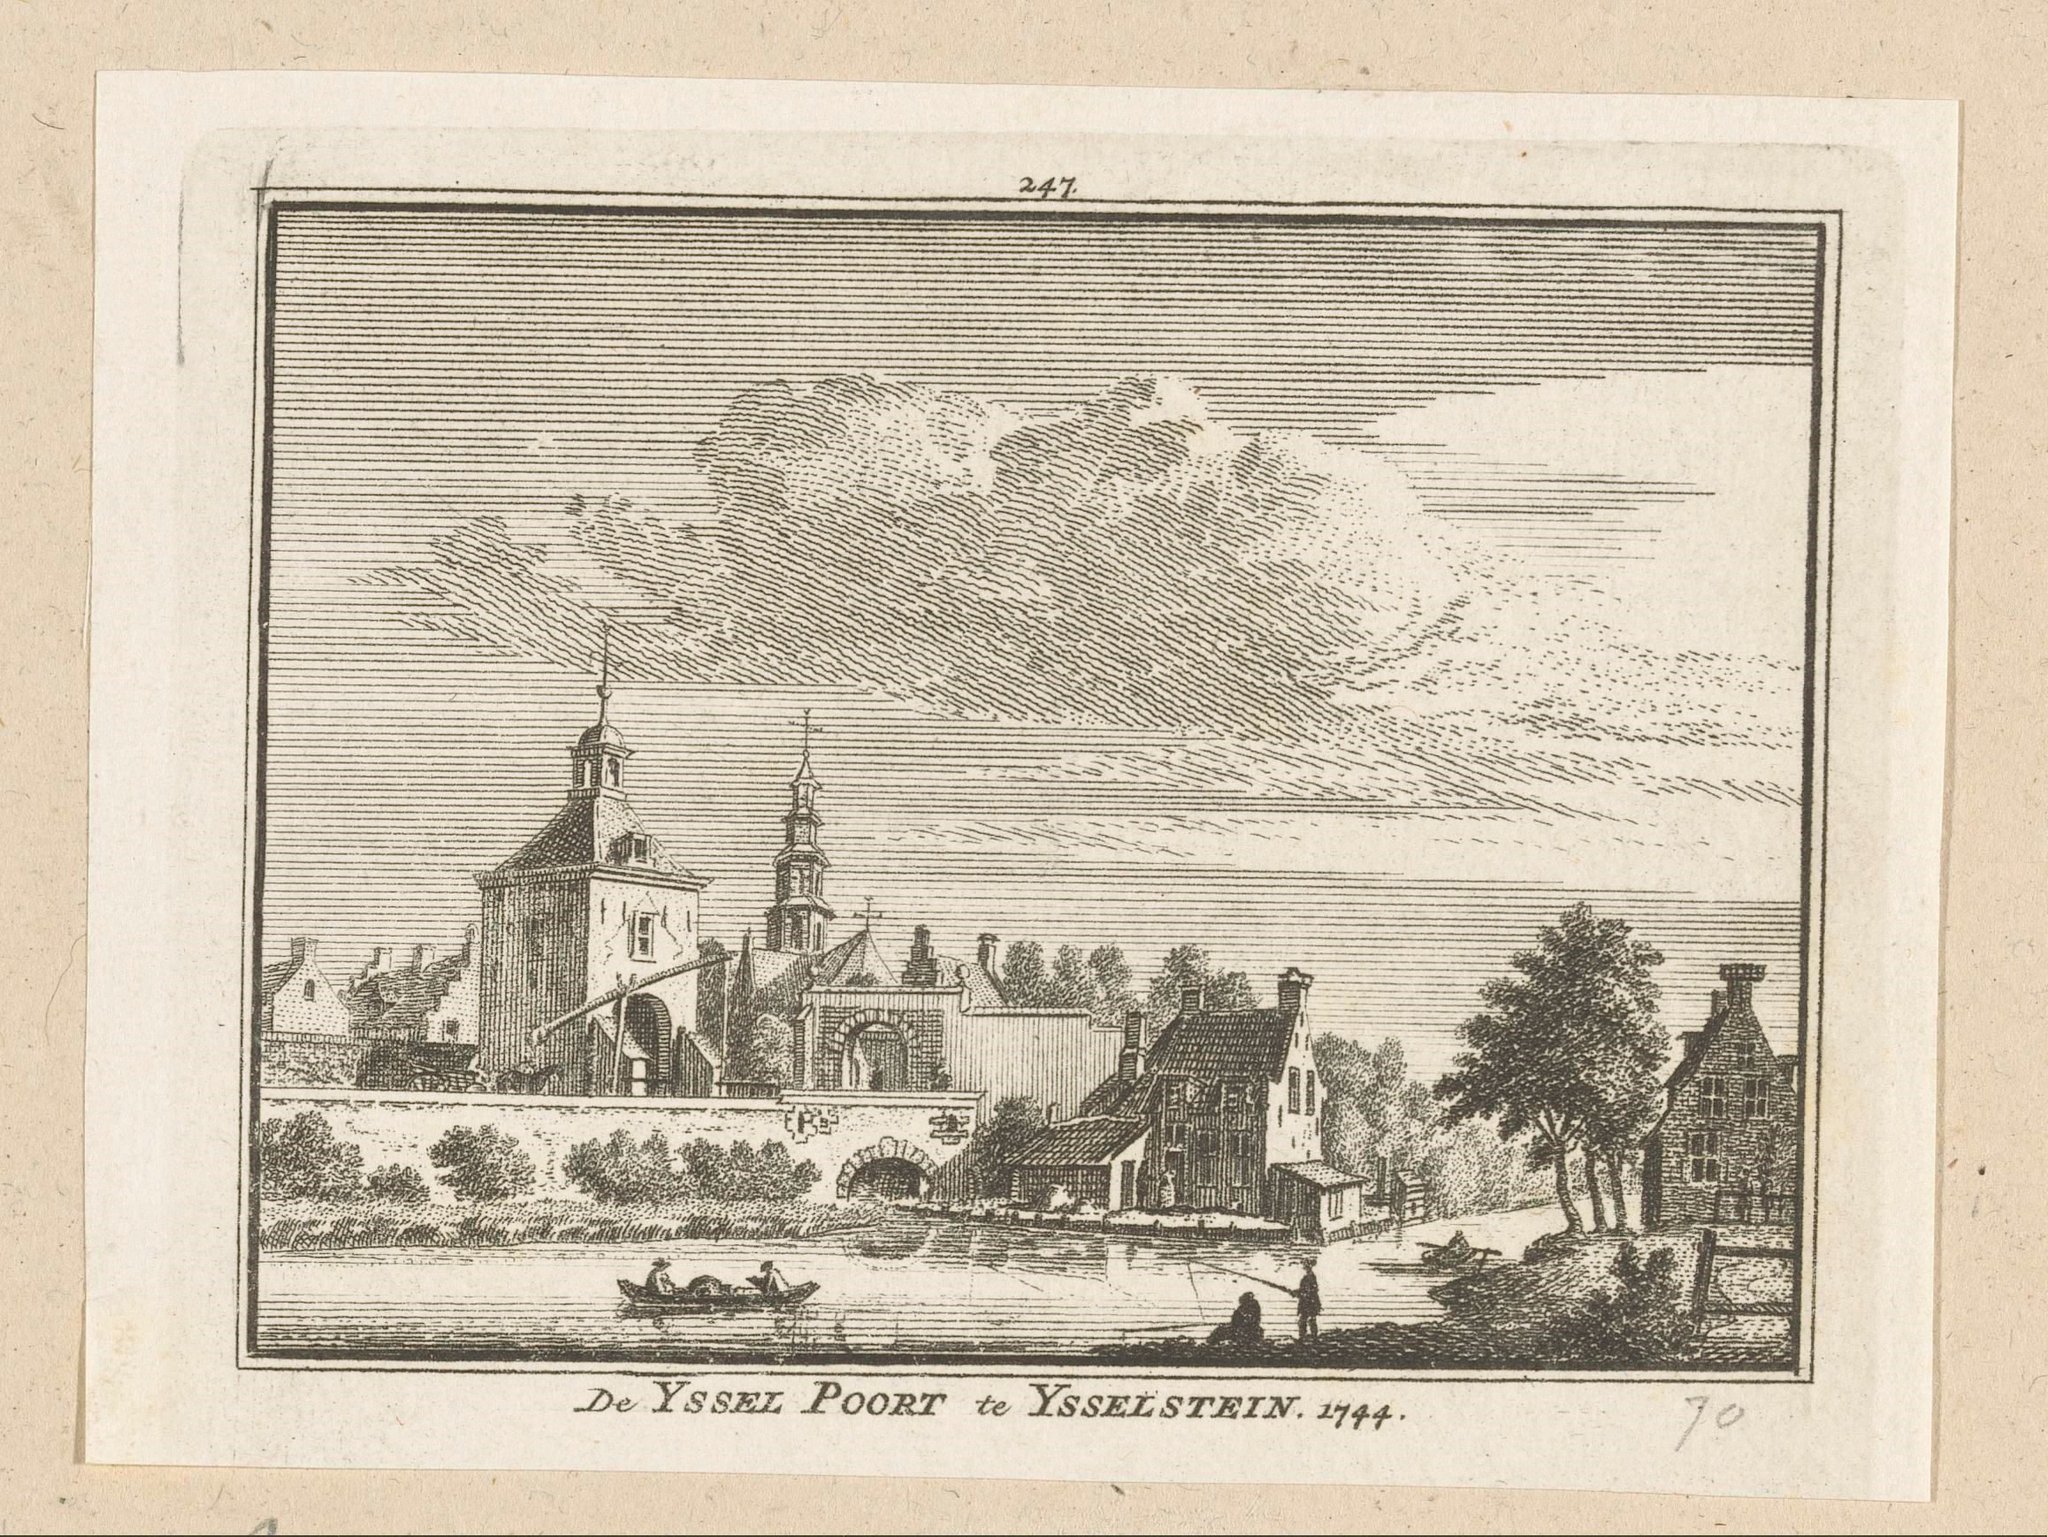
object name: print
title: Gezicht op de IJsselpoort te IJsselstein, 1744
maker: hendrik spilman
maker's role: draughtsman, painter, print maker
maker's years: 1721-1784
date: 1750-1792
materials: paper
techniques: etching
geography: haarlem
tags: city-gate, bridge in village across river, canal, etc. (+ city(-scape) with figures, staffage)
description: Prent ook gebruikt in: Het verheerlykt Nederland of kabinet van hedendaagsche gezigten van steden, dorpen (…). 9 delen. Amsterdam: Isaak Tirion en weduwe Isaak Tirion, 1745-1774, dl. 3 (1750), ill. 247. Of in: Nederlandsche tafereelen; of eene keurige verzameling van negen honderd fraaije gezigten van steden, dorpen, sloten, oudheden (….). 9 delen. Amsterdam: Jan de Groot, 1792, dl. 3, ill. 247.